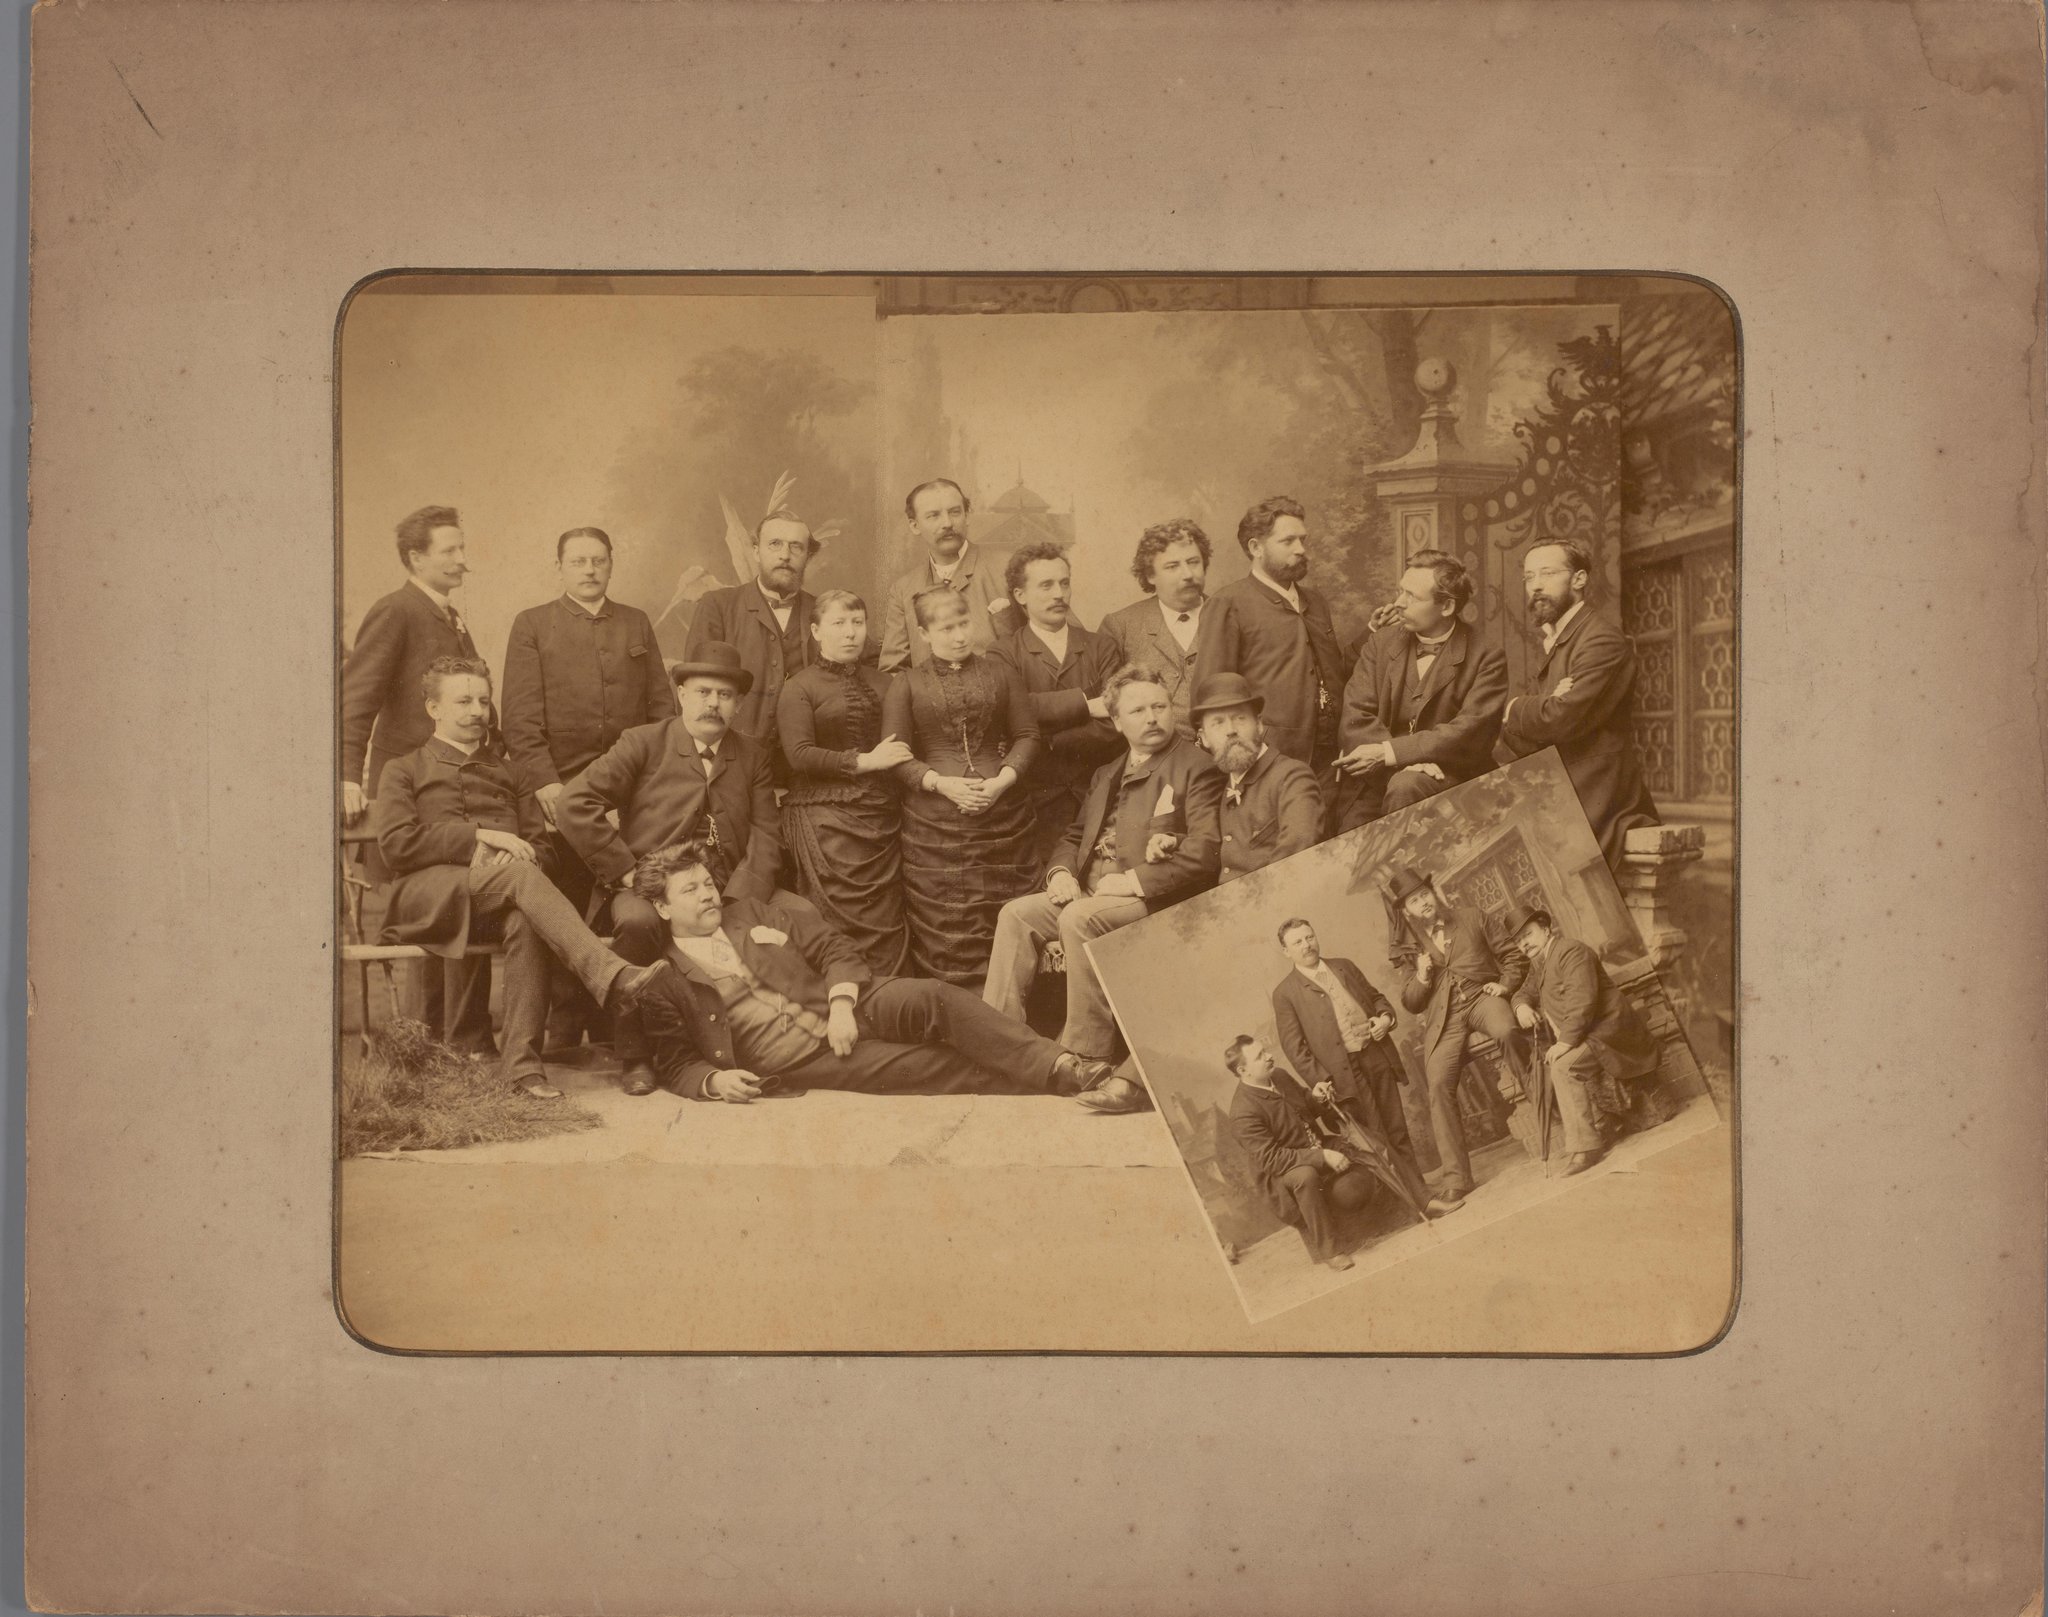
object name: photomontage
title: Groepsportret van een onbekend gezelschap met ingezet portret van vier van hen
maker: Anonymous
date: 1890-1910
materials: cardboard, paper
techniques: albumen print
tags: anonymous historical persons portrayed in a group, in a group-portrait